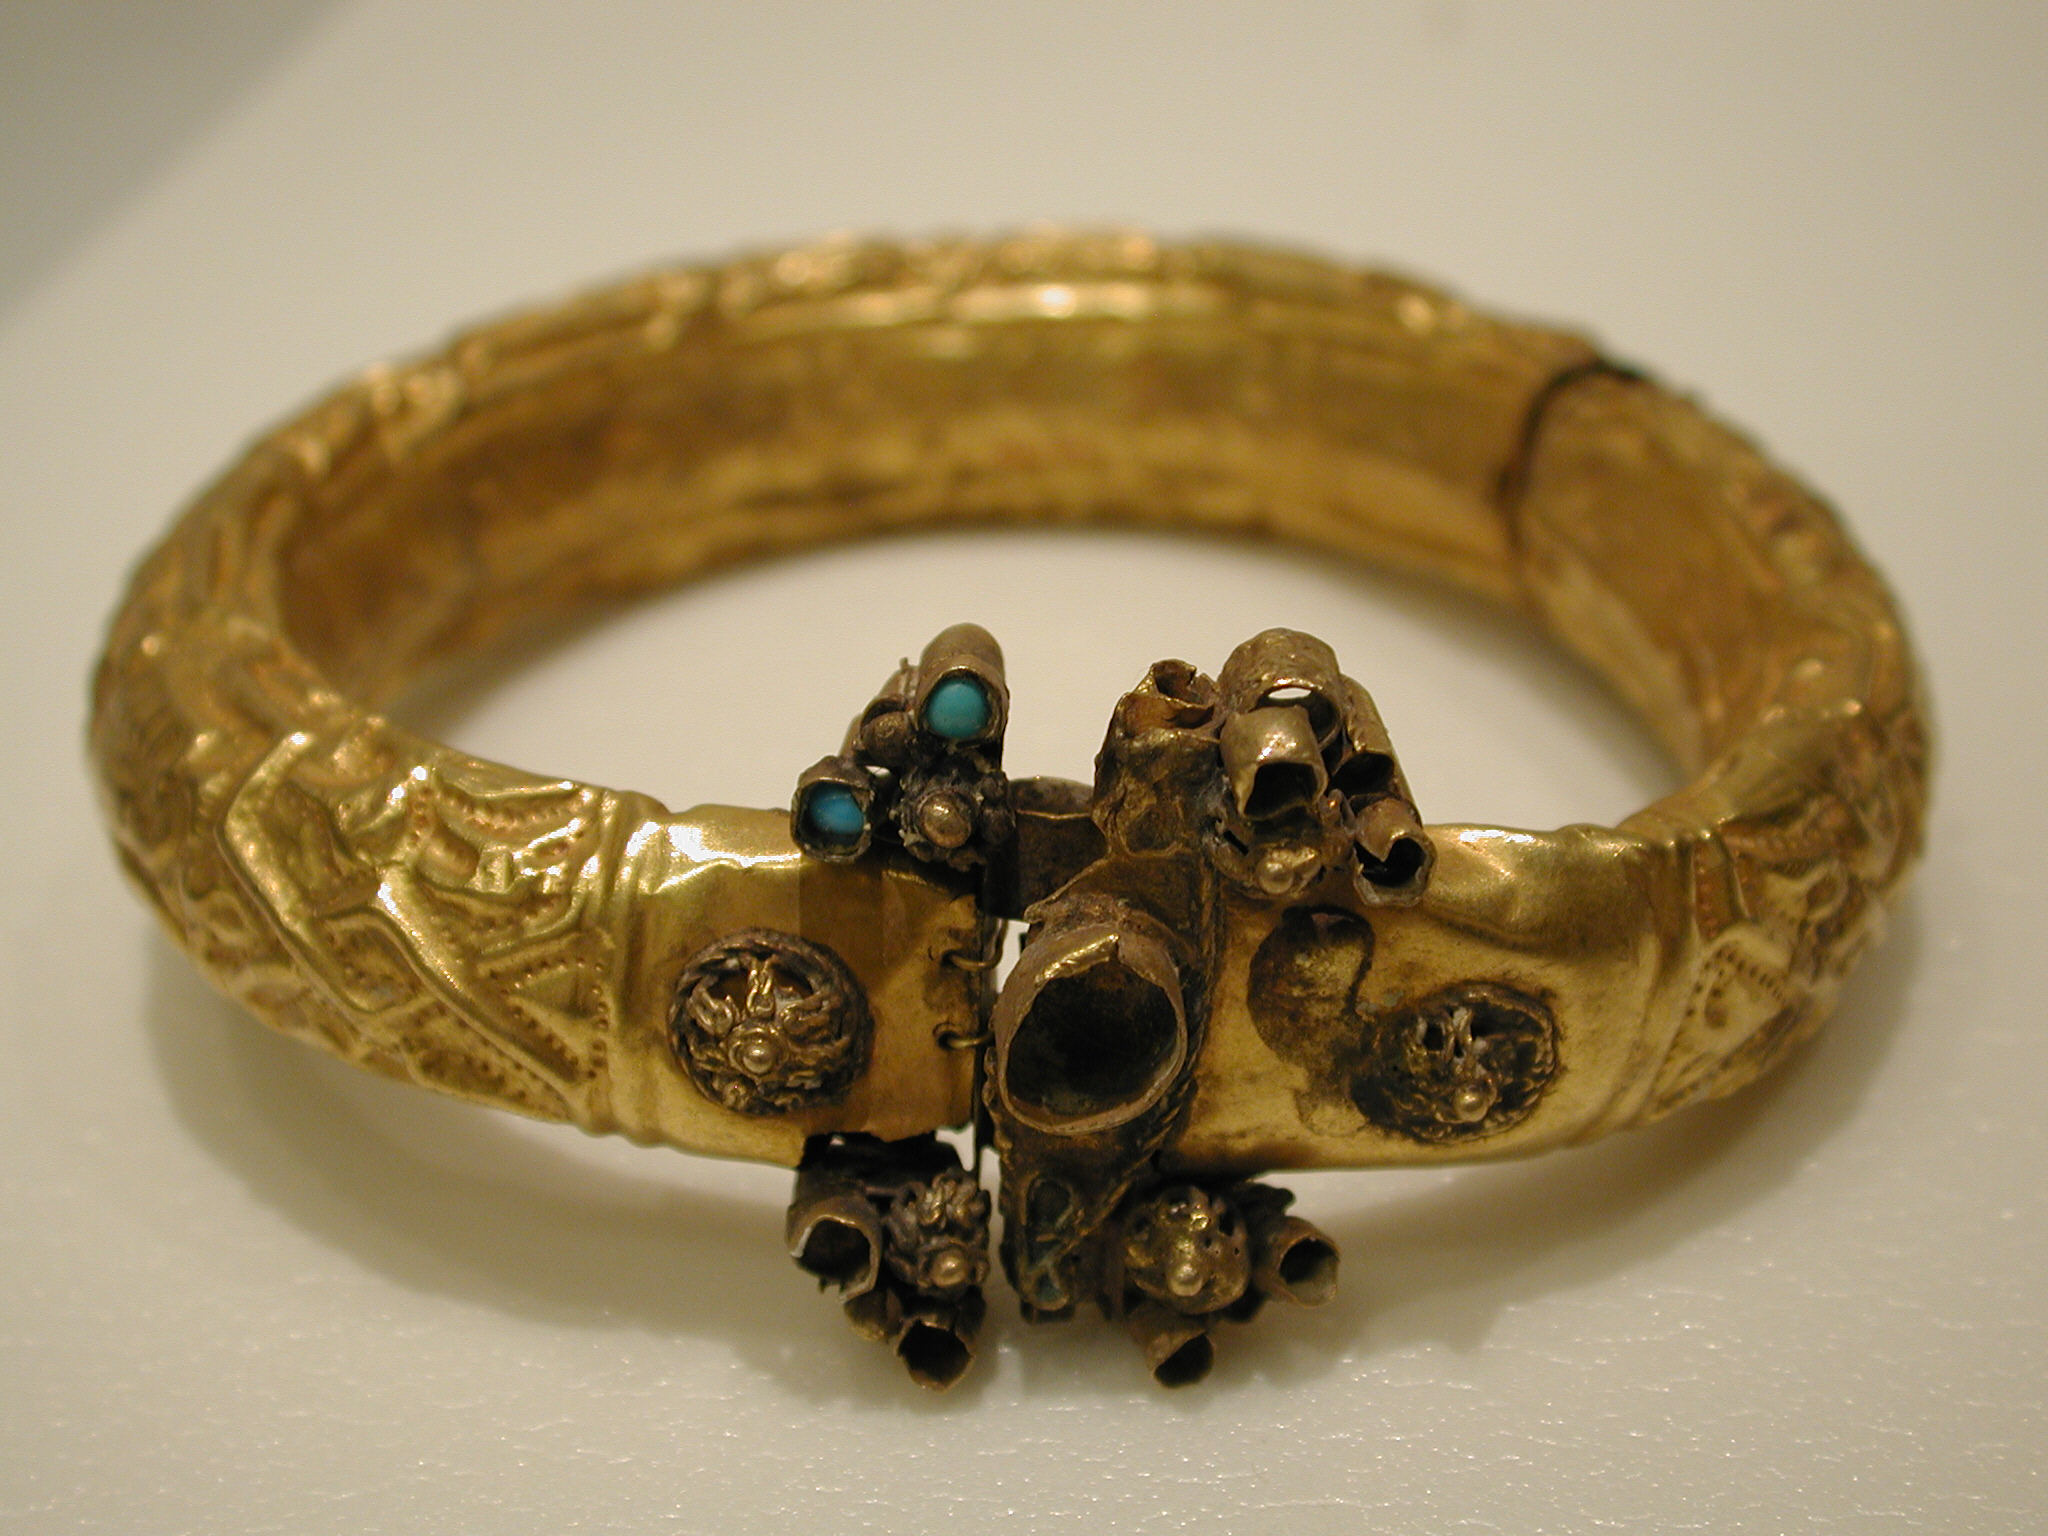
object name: bracelet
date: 1001-1200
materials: gold, metal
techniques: punching, repoussé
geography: syria